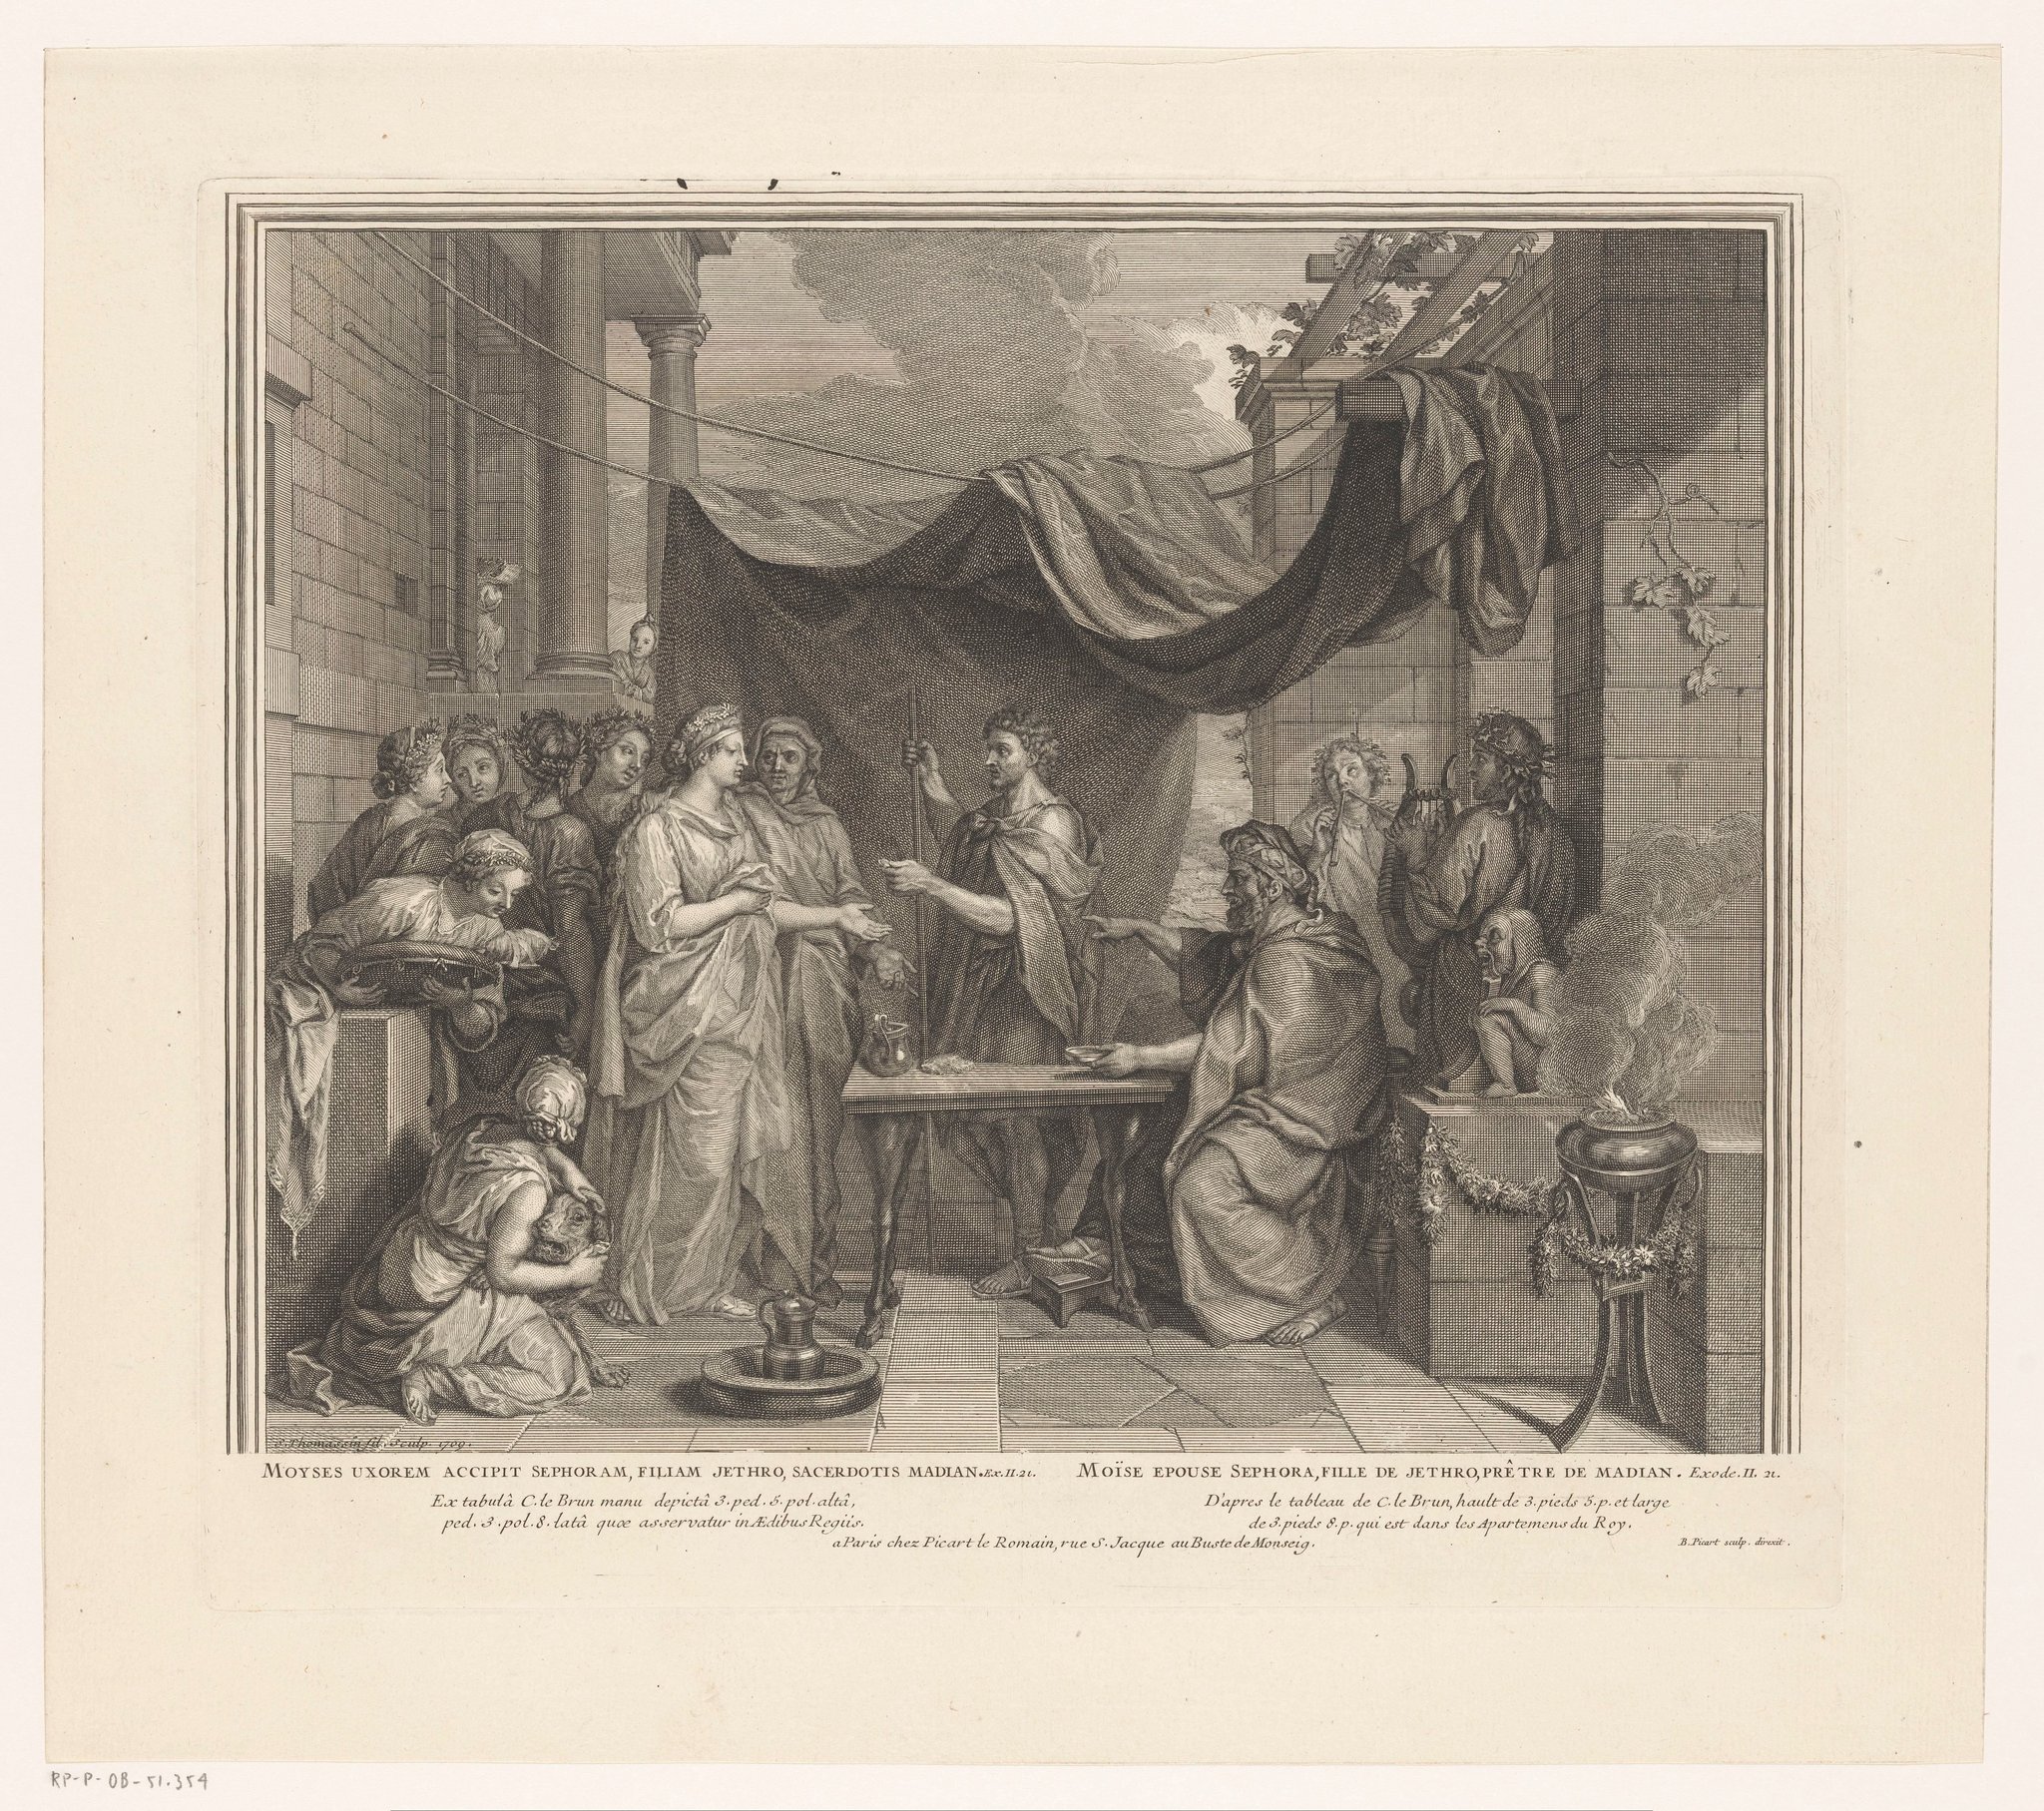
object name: print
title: Huwelijk van Mozes en Sippora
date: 1709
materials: paper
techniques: engraving, etching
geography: france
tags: moses' marriage with zipporah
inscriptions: collector's mark: Lugt 240